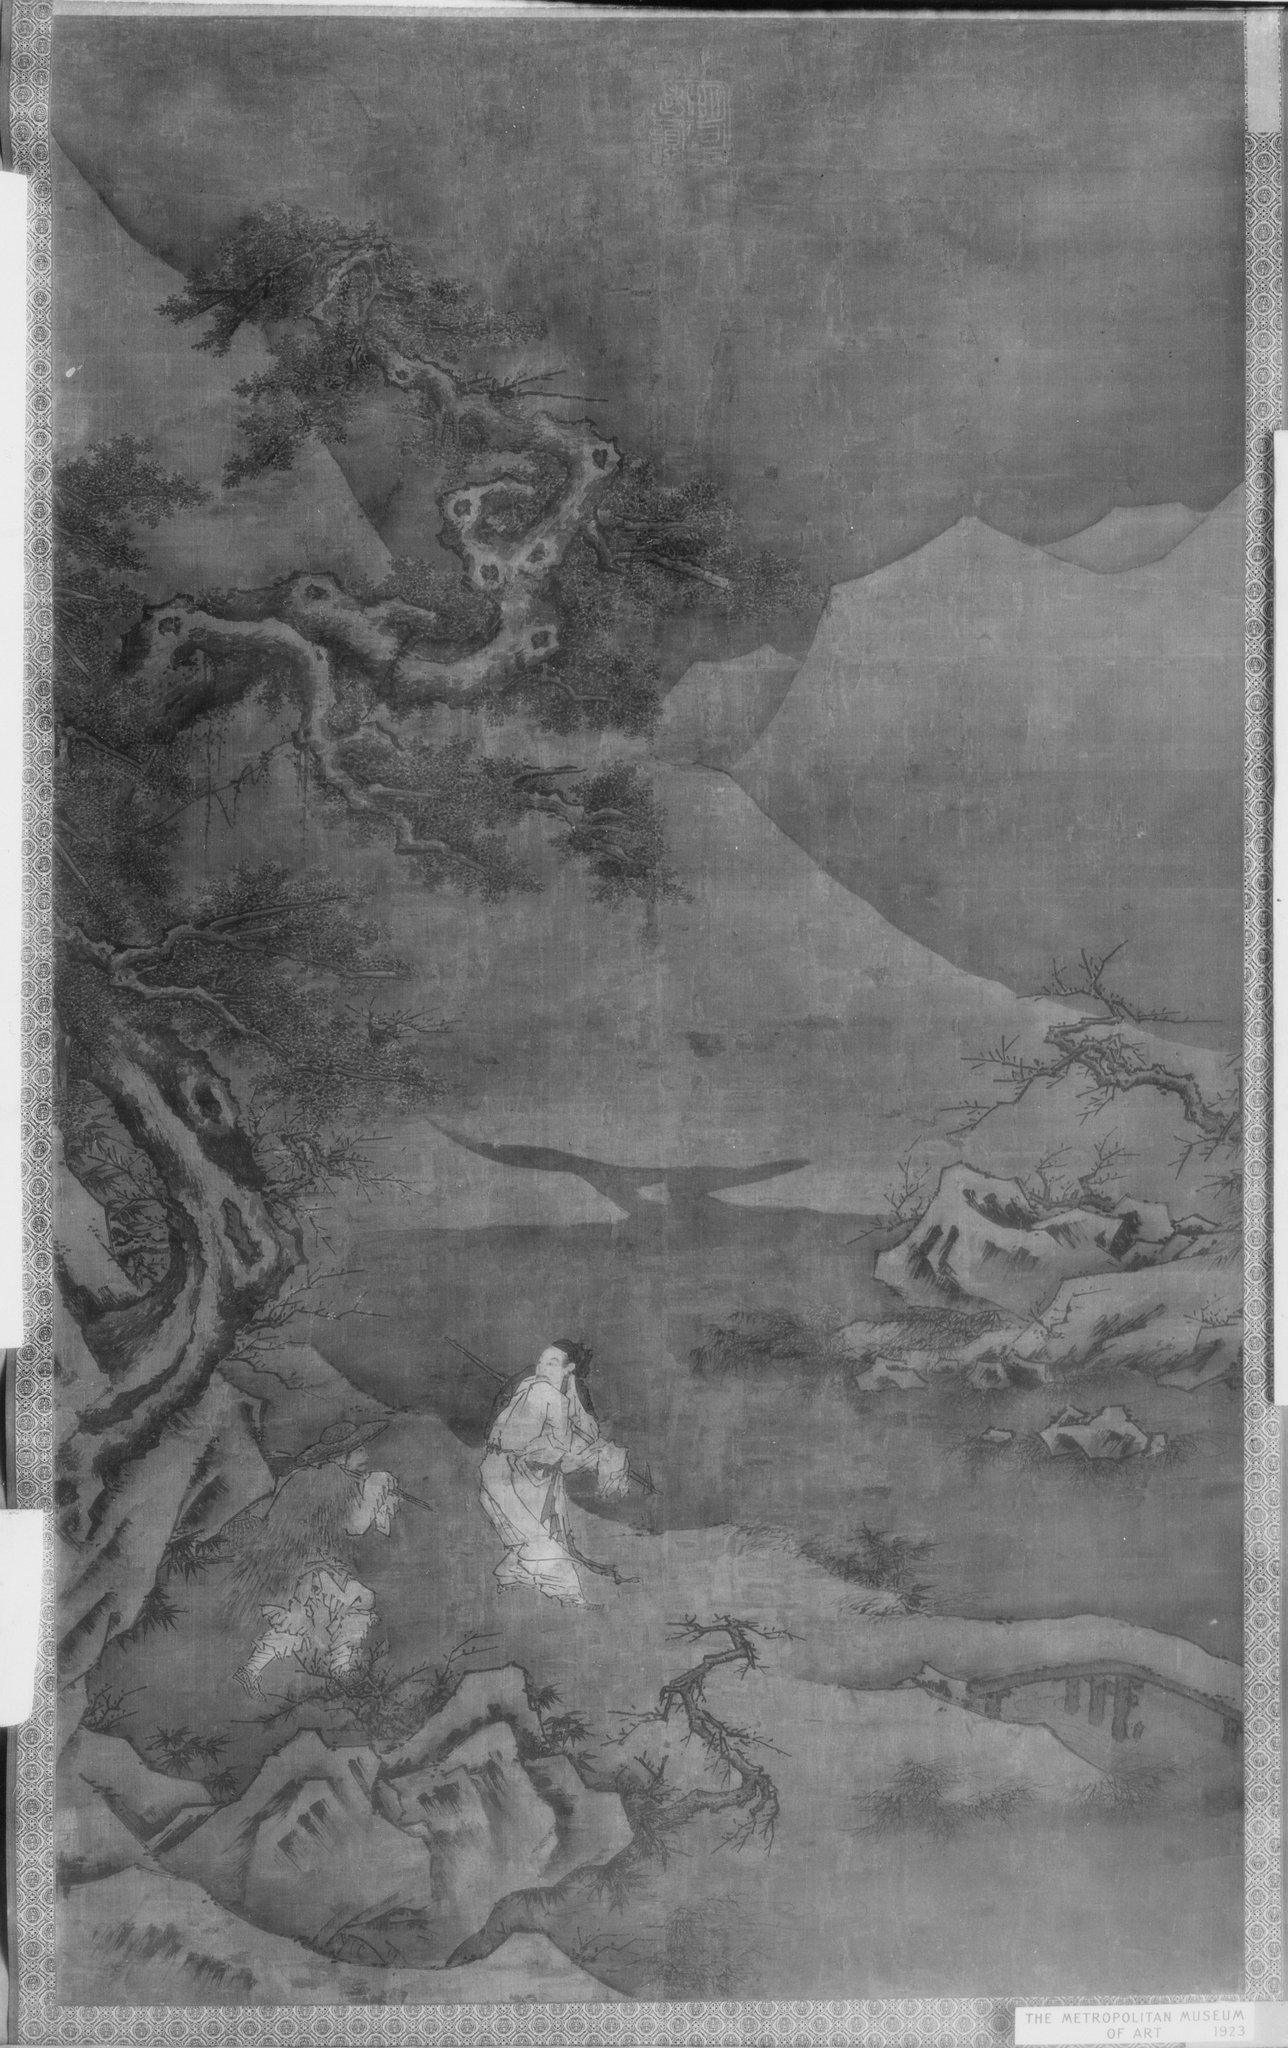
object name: hanging scroll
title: Travellers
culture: chinese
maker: unidentified artist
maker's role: artist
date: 1368-1911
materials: silk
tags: men,landscapes